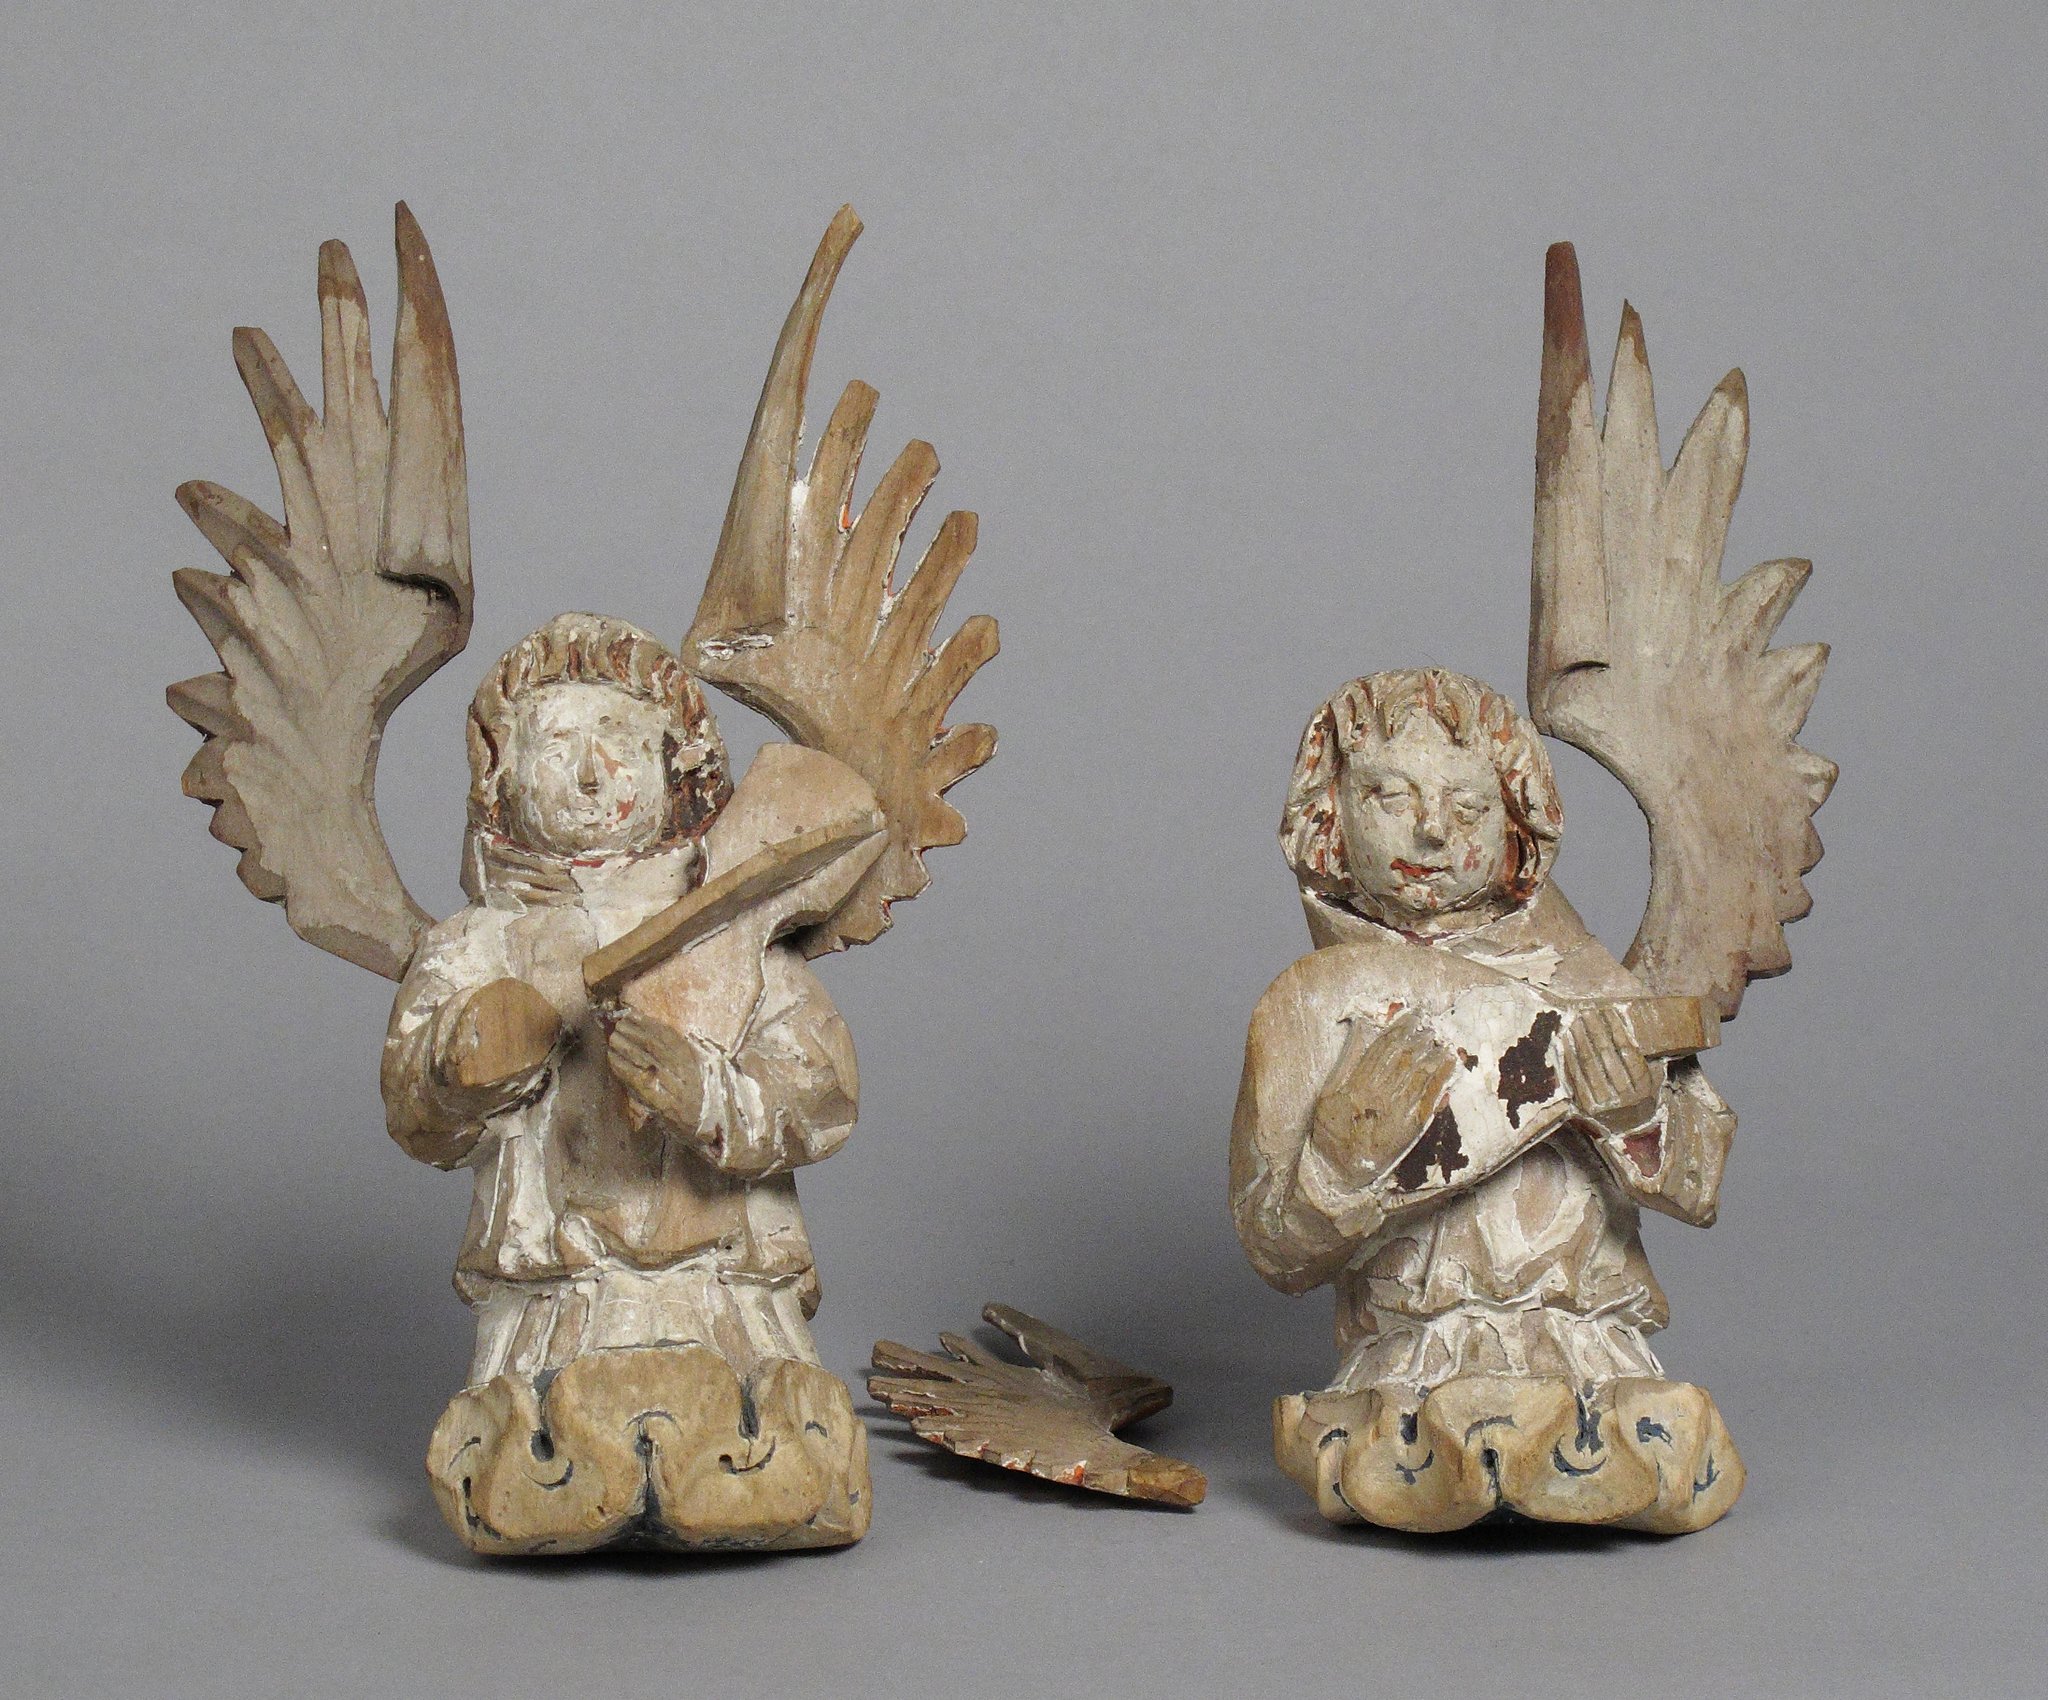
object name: relief statue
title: Angel Playing Instrument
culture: french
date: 1401-1500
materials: paint, wood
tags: musical instruments,angels